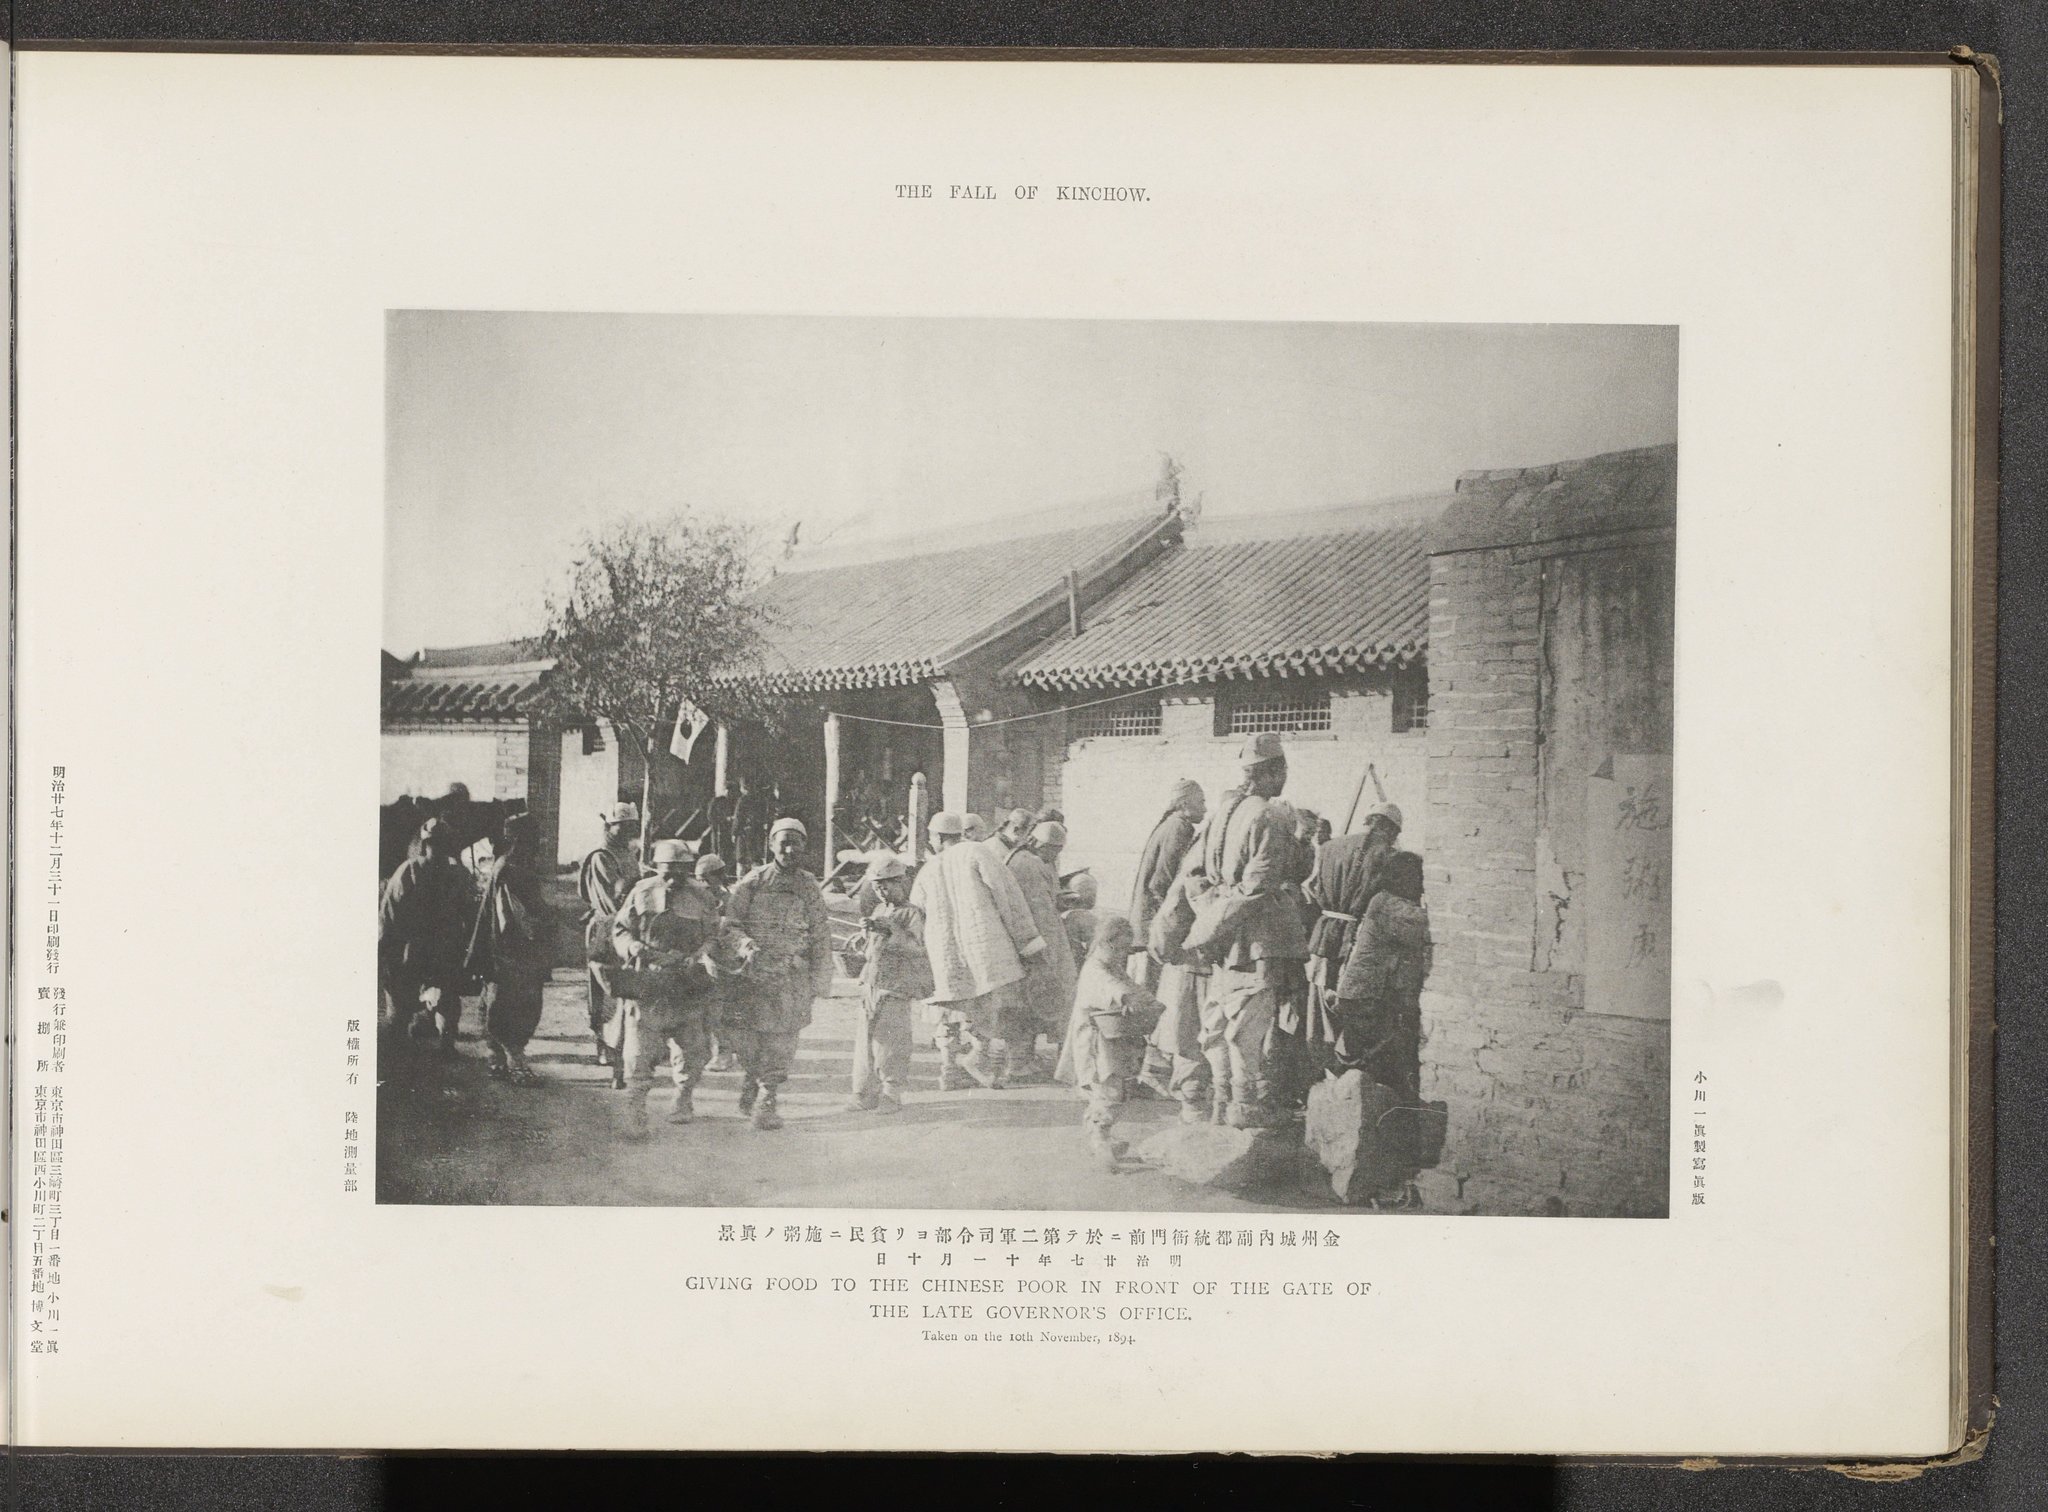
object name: photomechanical print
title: Giving food to the Chinese poor in front of the gate of the late governor's office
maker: kazumasa ogawa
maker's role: auteur, fotograaf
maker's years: 1860-1929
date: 1894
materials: paper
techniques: photograph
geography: manchuria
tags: giving alms or other charity, e.g.: handing out food, the soldier; the soldier's life, façade (of house or building)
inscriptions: inscription: ‘The fall of Kinchow.’